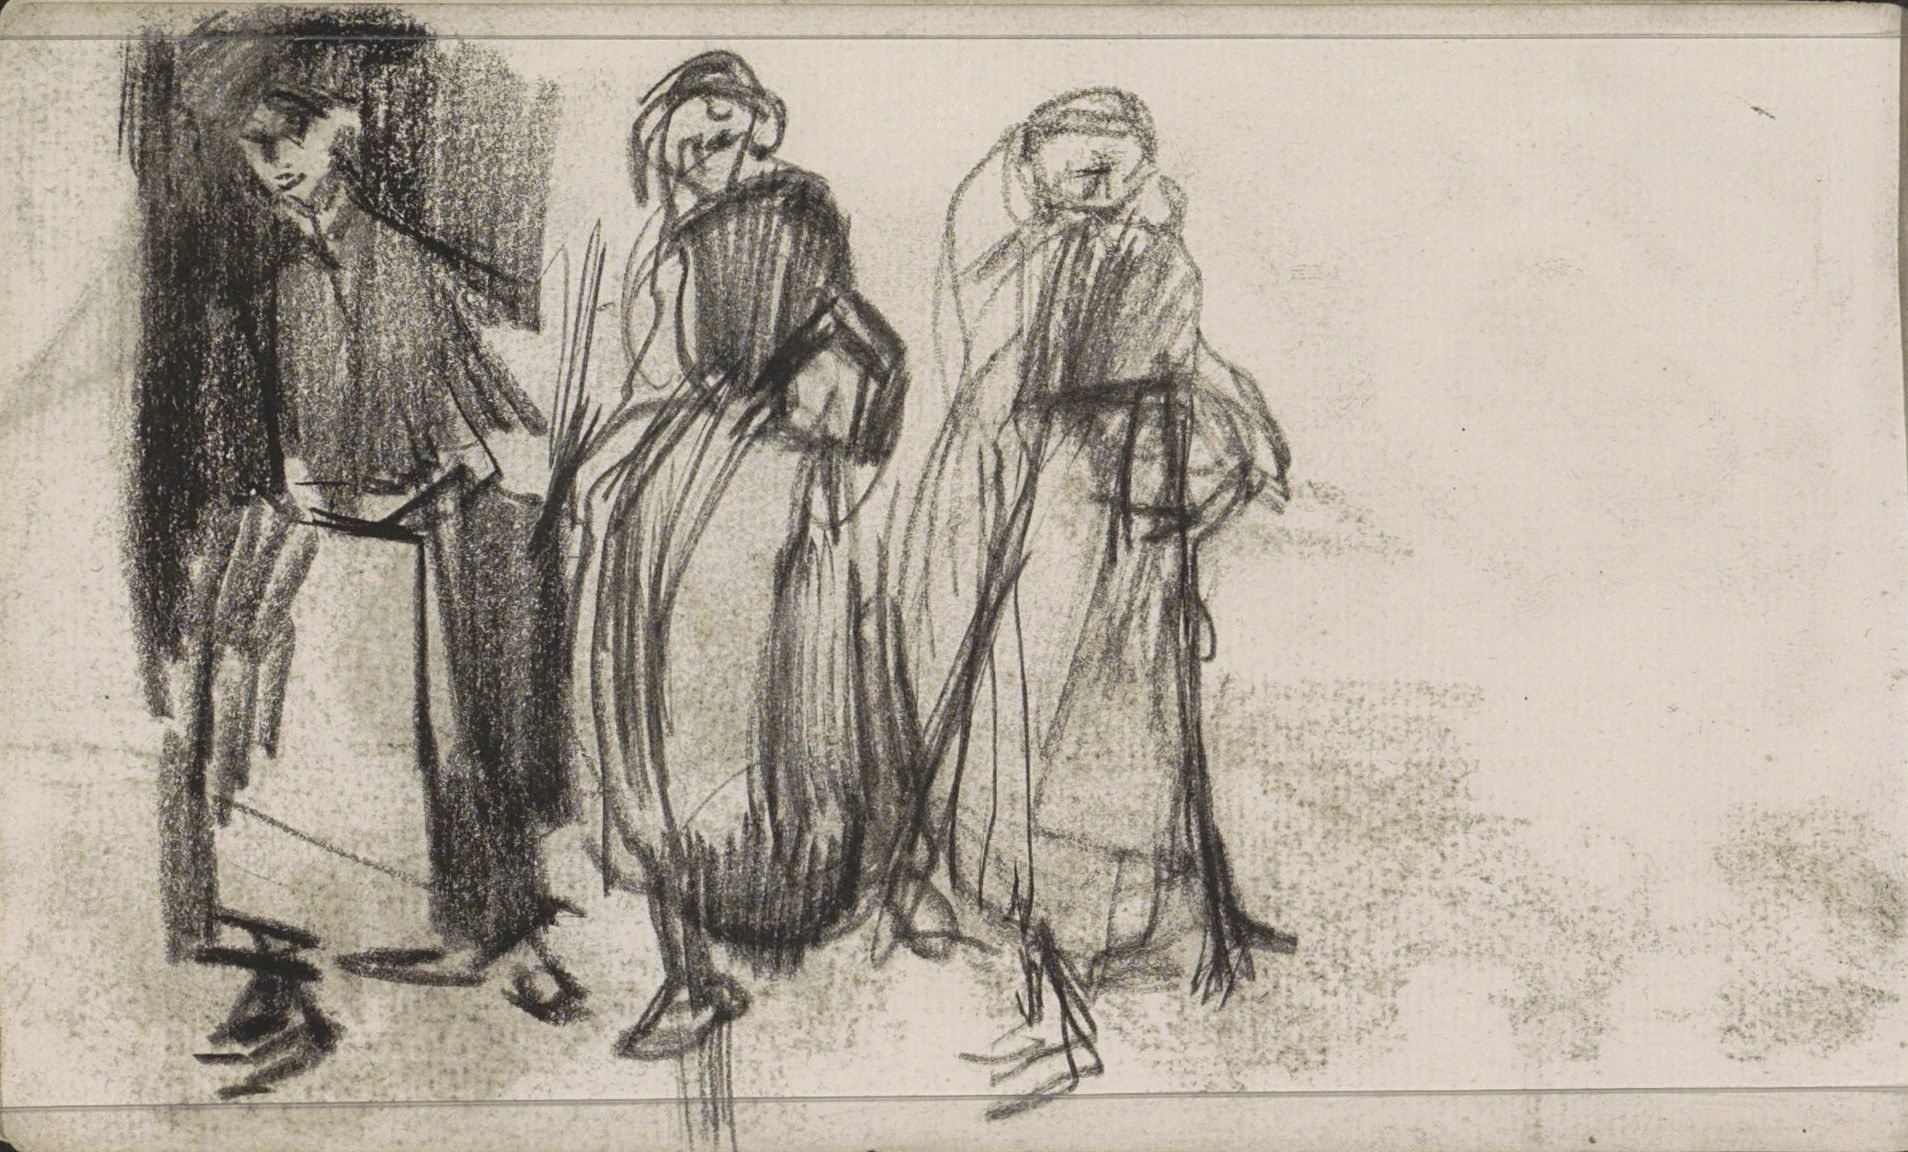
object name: sketchbook leaf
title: Drie staande vrouwen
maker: isaac israels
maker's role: draughtsman, painter, print maker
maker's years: 1865-1934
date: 1875-1934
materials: chalk, paper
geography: the hague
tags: adult woman (+ standing)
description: Pagina 4 uit schetsboek XLVIII met 62 pagina's.